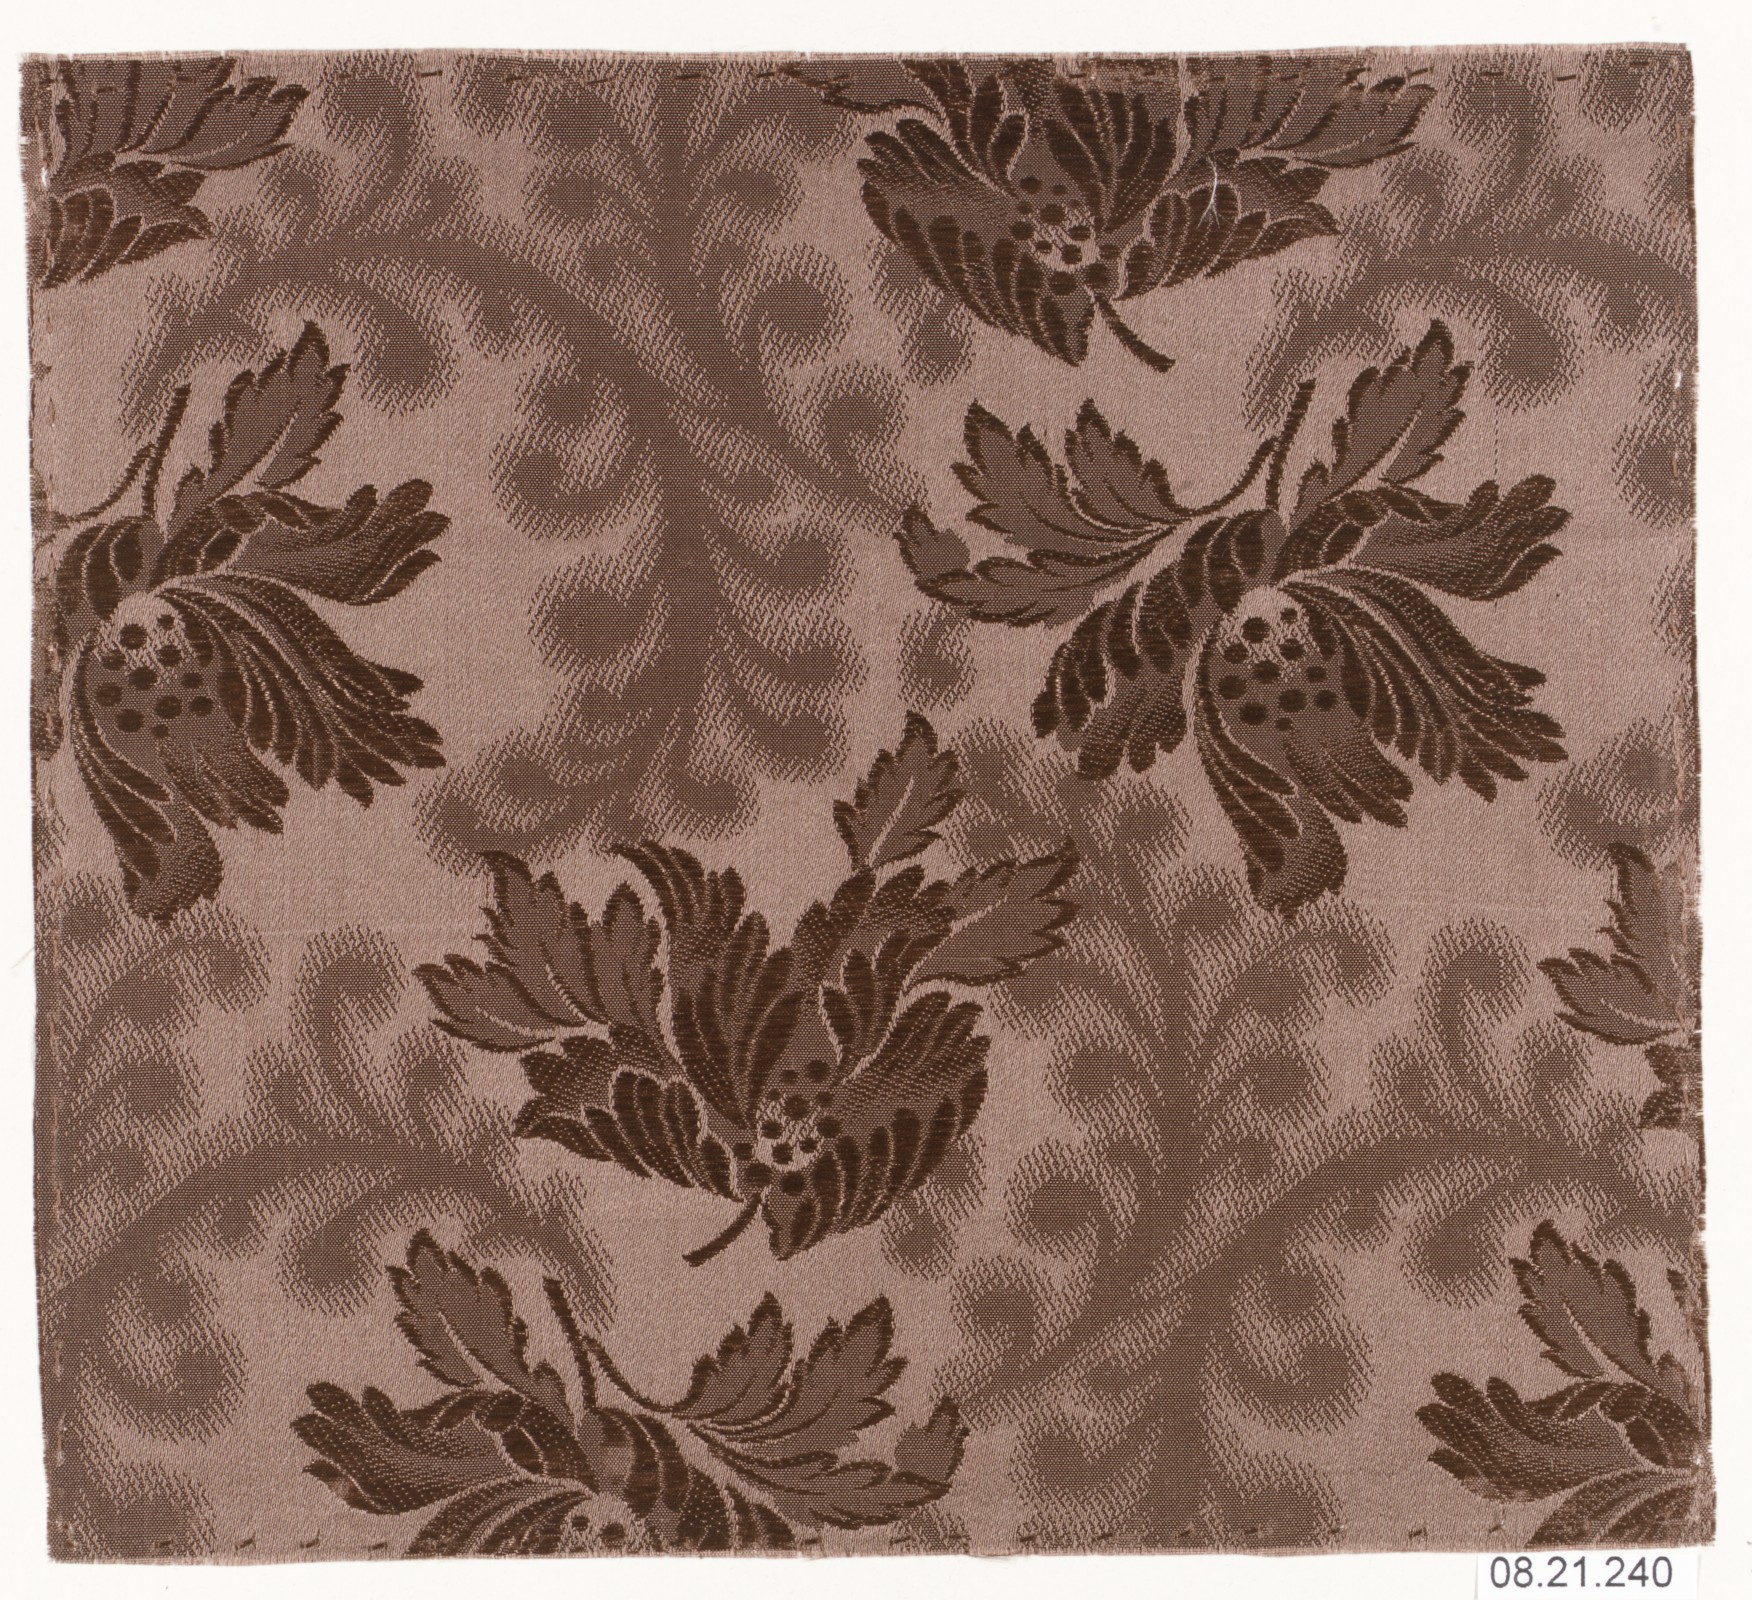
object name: textile sample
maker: Anonymous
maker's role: designer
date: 1900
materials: silk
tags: leaves